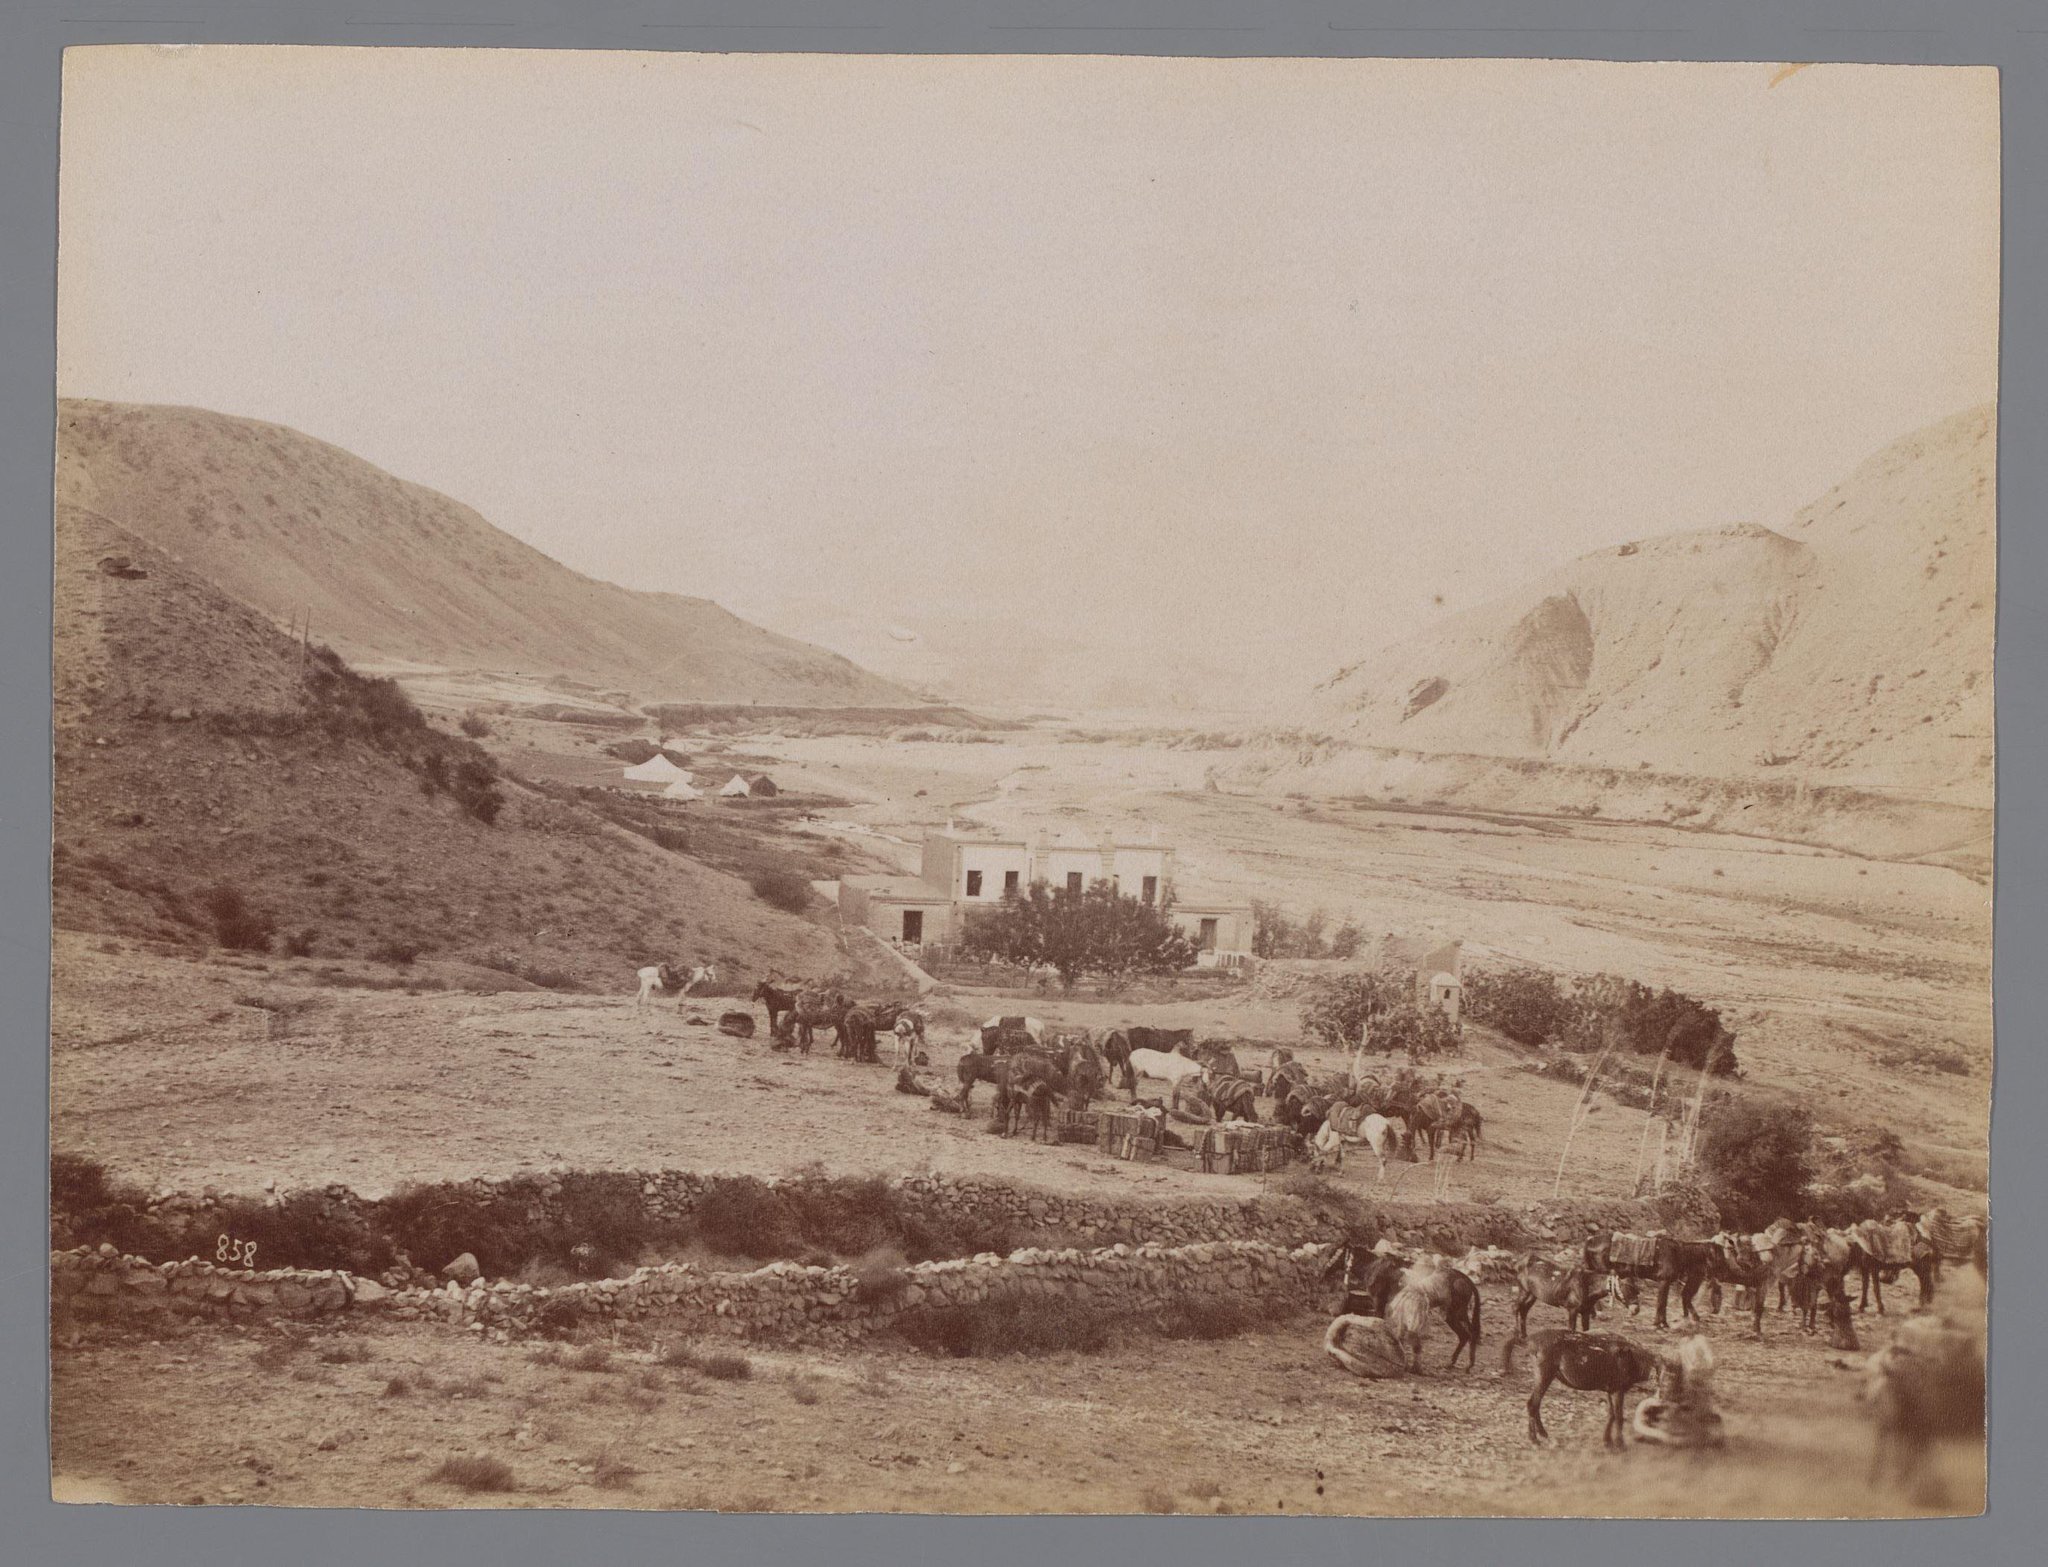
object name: photograph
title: Landschap, "La route de Rescht, Paitchenar [?]", Iran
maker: antoine sevruguin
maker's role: fotograaf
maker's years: 1840-1933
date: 1885-1910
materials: paper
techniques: albumen print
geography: iran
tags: iran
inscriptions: number: ‘858’, inscription: ‘La route de Rescht//Paitchenar [?]’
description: Landschap omringd door bergen, met enkele huizen en grazende paarden, Iran.